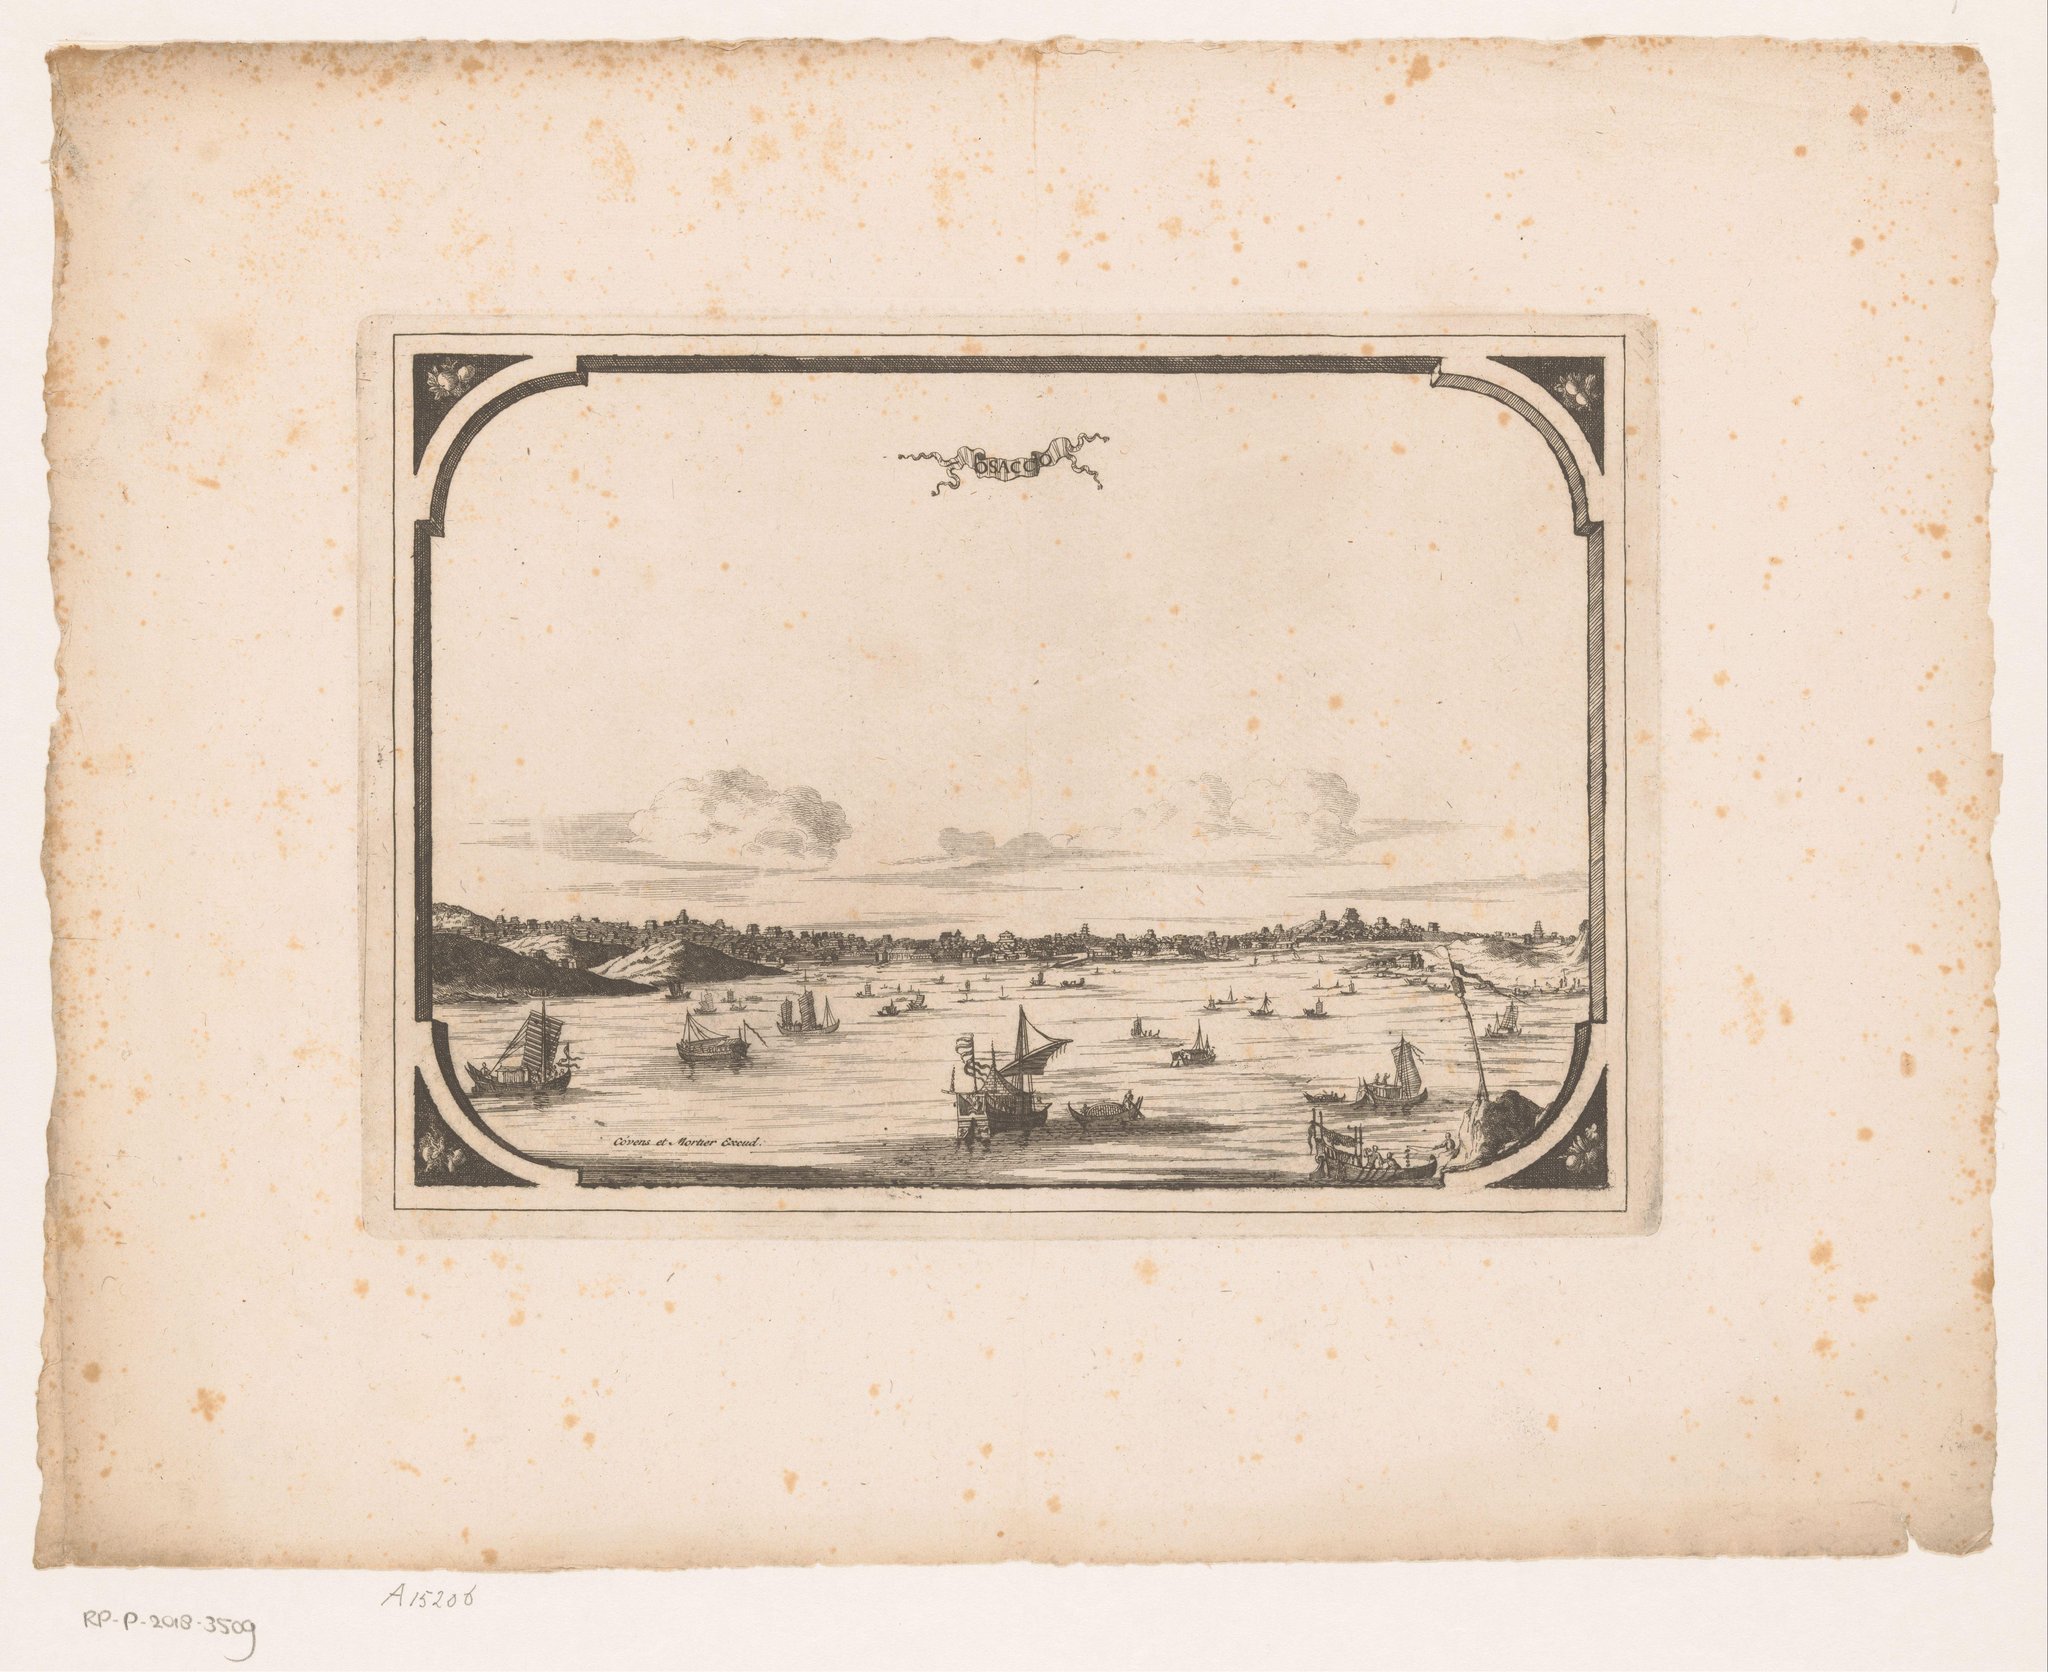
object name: print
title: Osacco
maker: Anonymous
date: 1721-1774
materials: paper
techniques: engraving, etching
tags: harbour, prospect of city, town panorama, silhouette of city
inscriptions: collector's mark: Lugt 2228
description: Gezicht vanaf zee, met zeil- en roeiboten in lokale stijl. Op de achtergrond het silhouet van de stad.